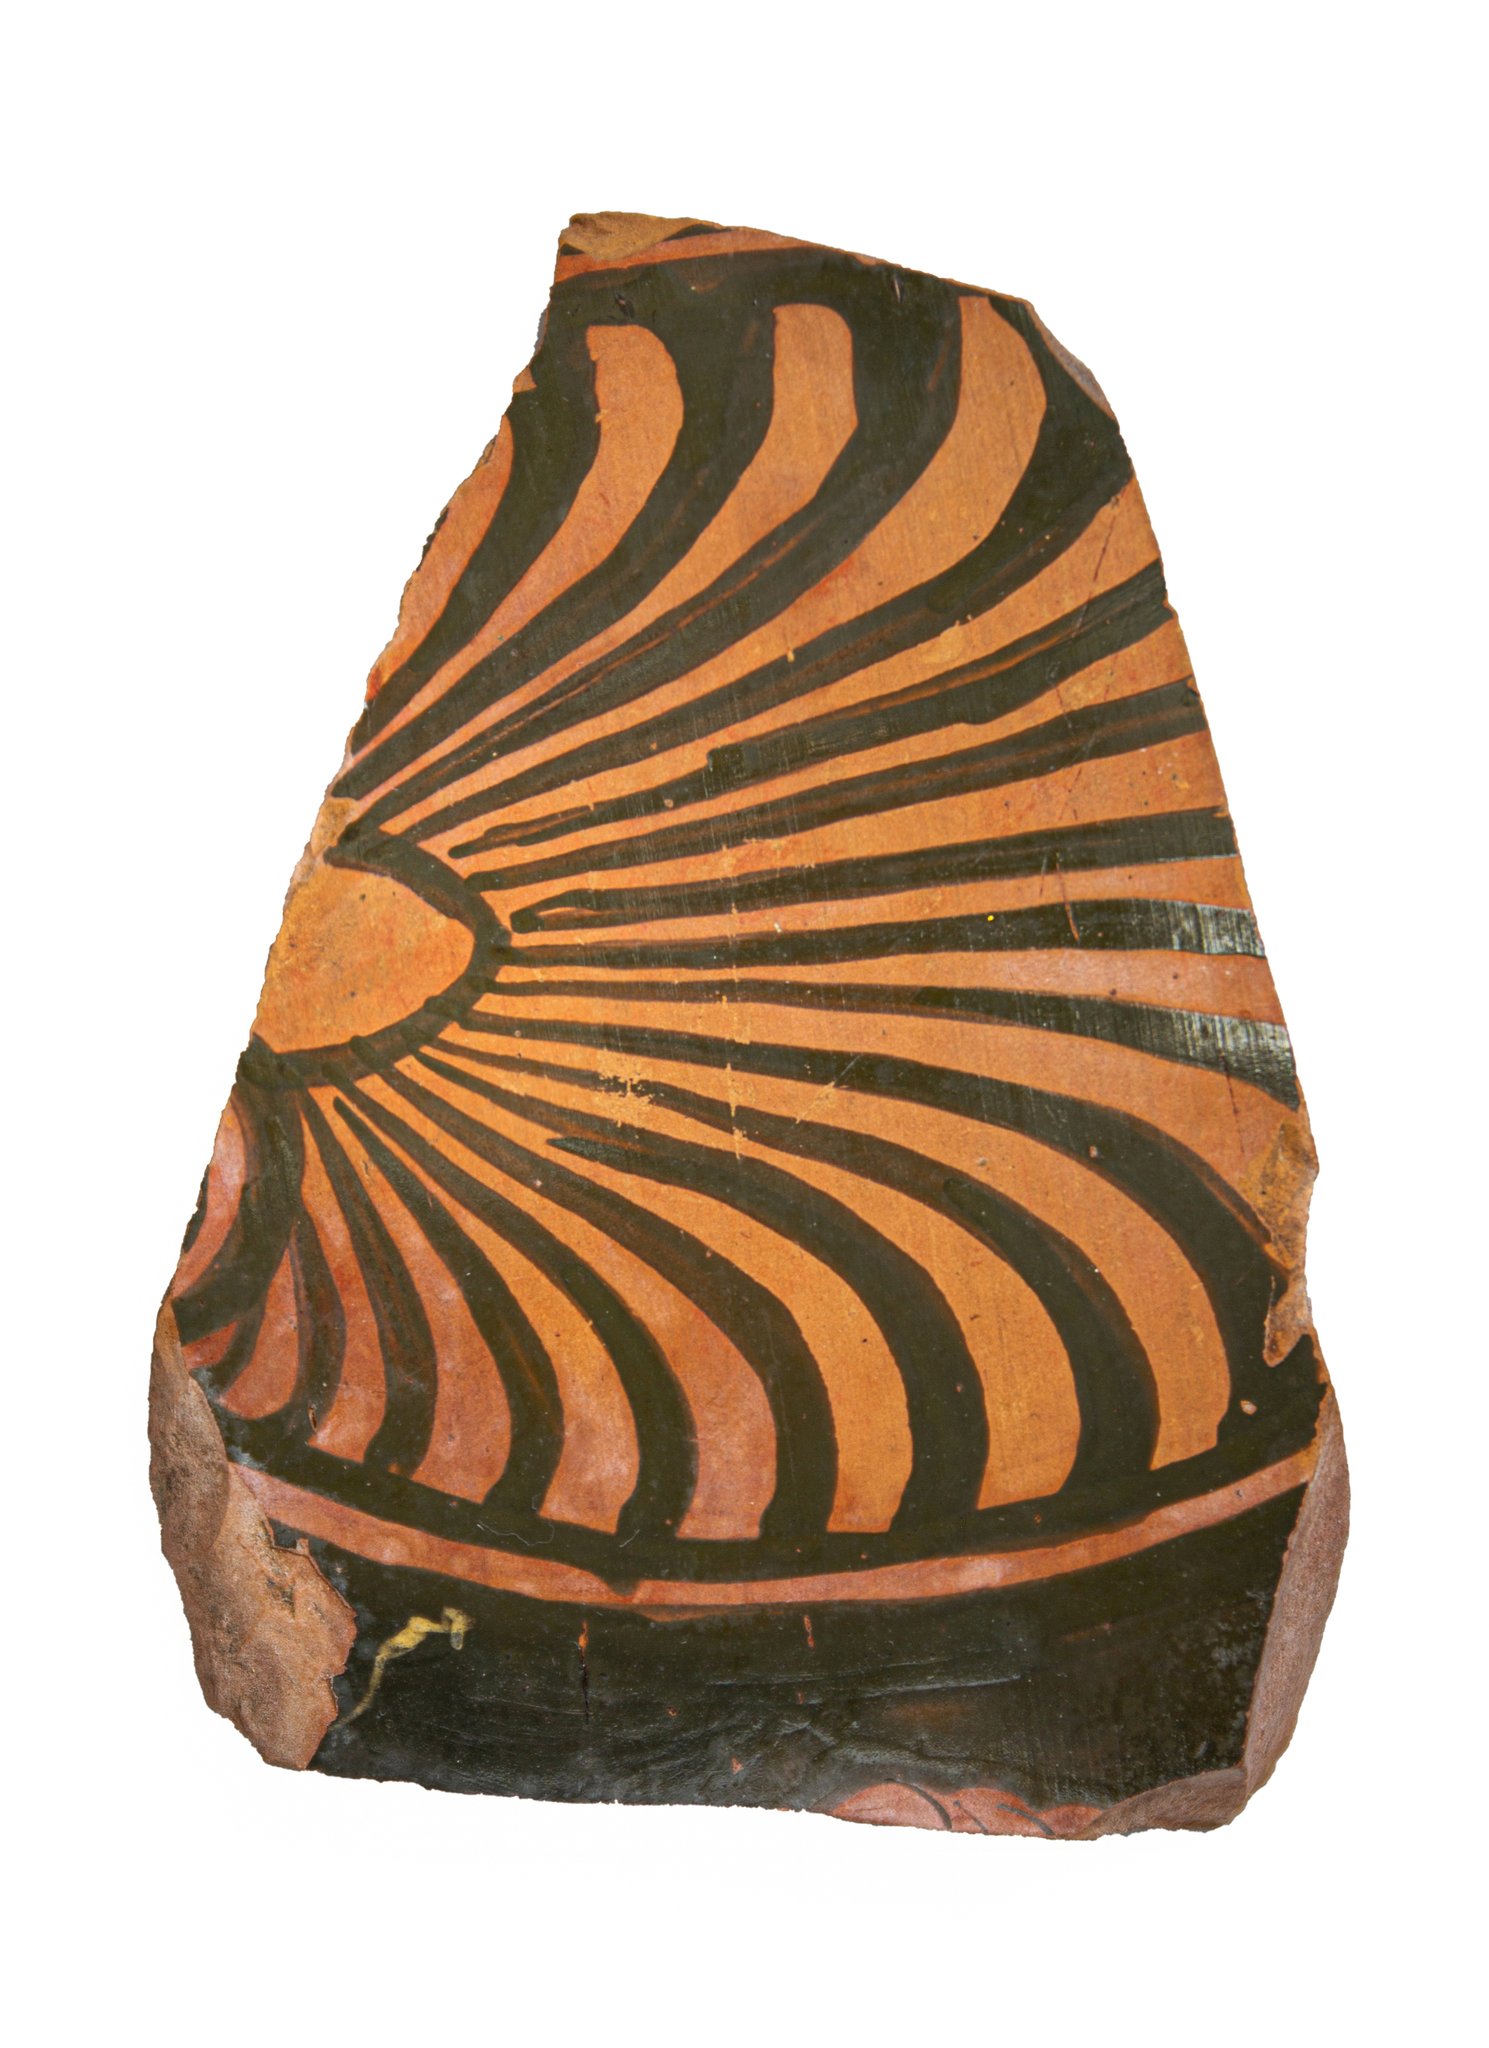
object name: volute krater fragment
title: Volute-krater fragment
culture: greek, south italian, apulian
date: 400-301 BCE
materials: terracotta